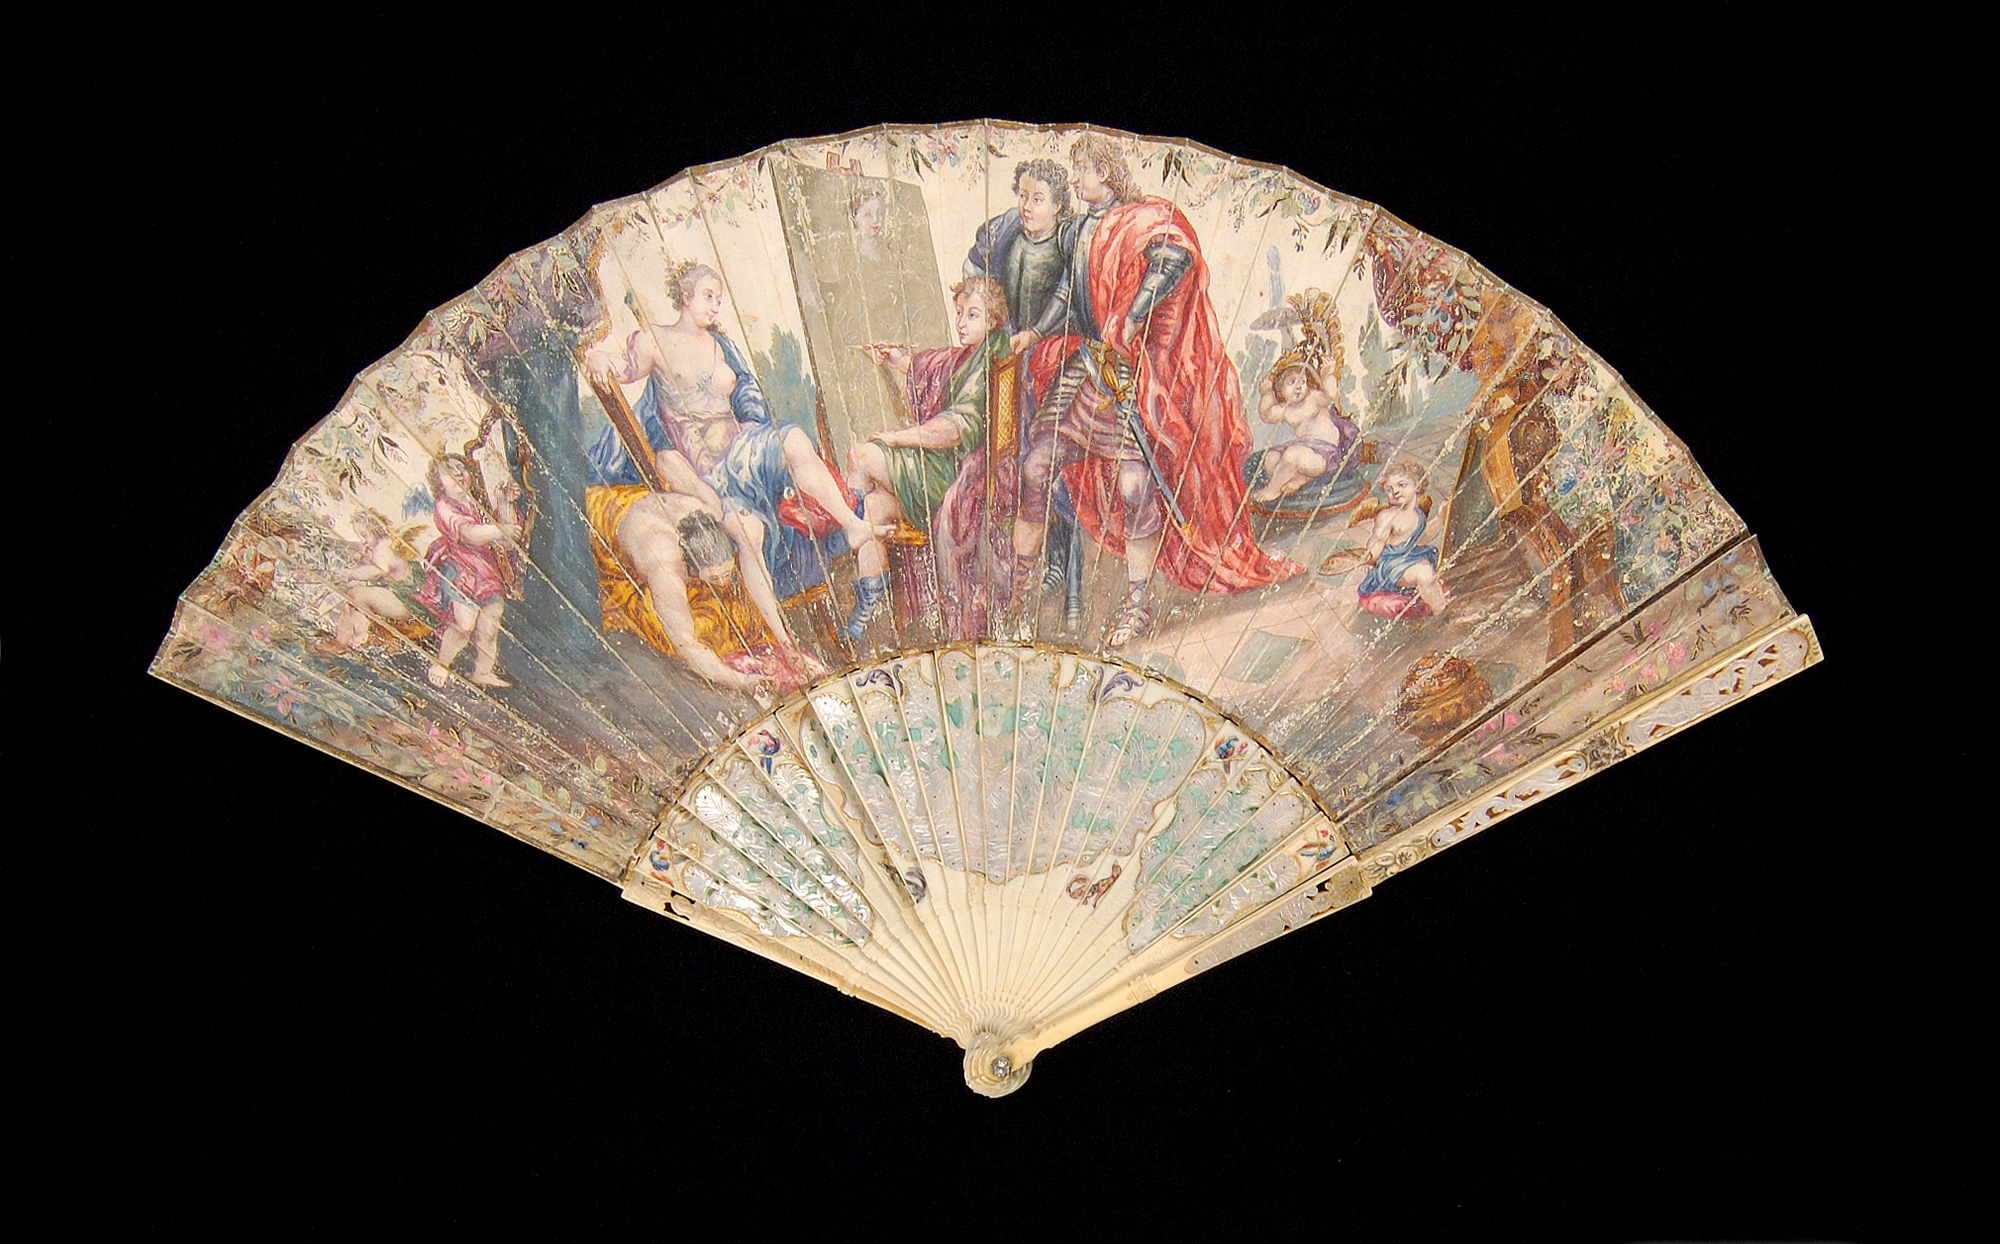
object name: fan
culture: french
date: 1767-1800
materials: ivory, mother of pearl, paper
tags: painting,men,women,cupid